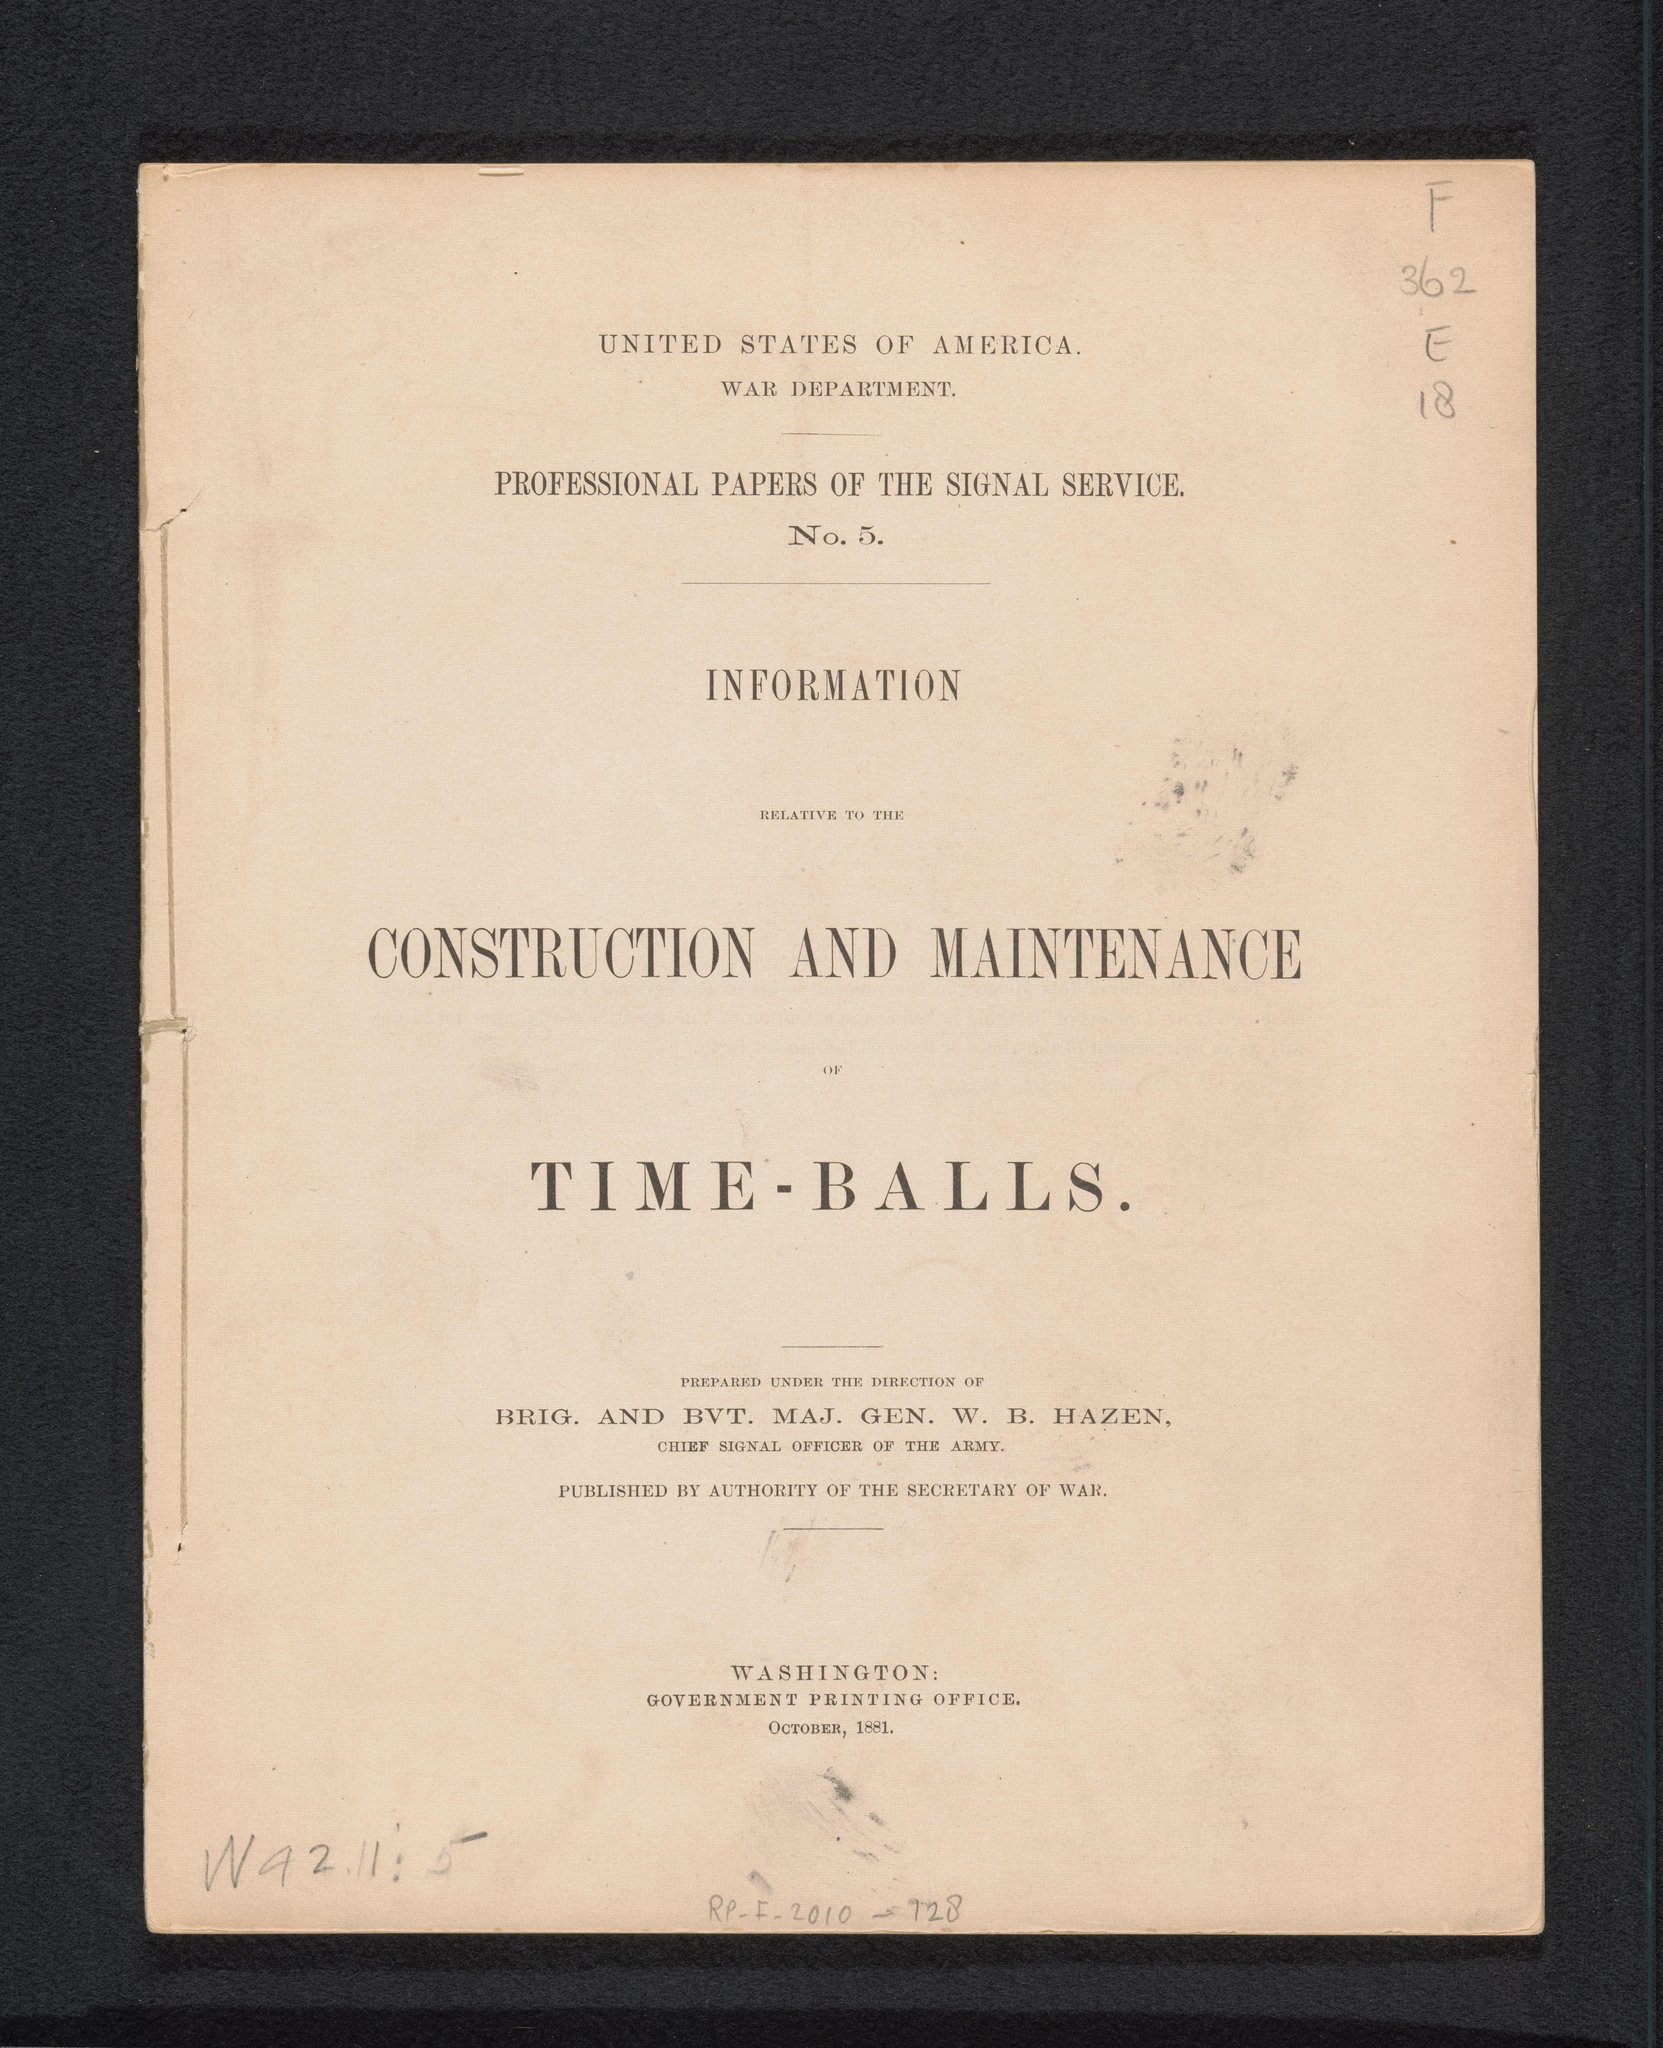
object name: book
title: Information relative to the construction and maintenance of time-balls / prepared under the dir. of W.B. Hazen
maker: william babcock hazen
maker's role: generaal, militair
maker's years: 1830-1887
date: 1881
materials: paper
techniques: photograph, printing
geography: washington d.c.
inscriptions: annotation: ‘Whitman College Library,/ Donated by Chief Signal Officer [.].S.A./ Jan. 13 1883.’, annotation: ‘W42.11:5’